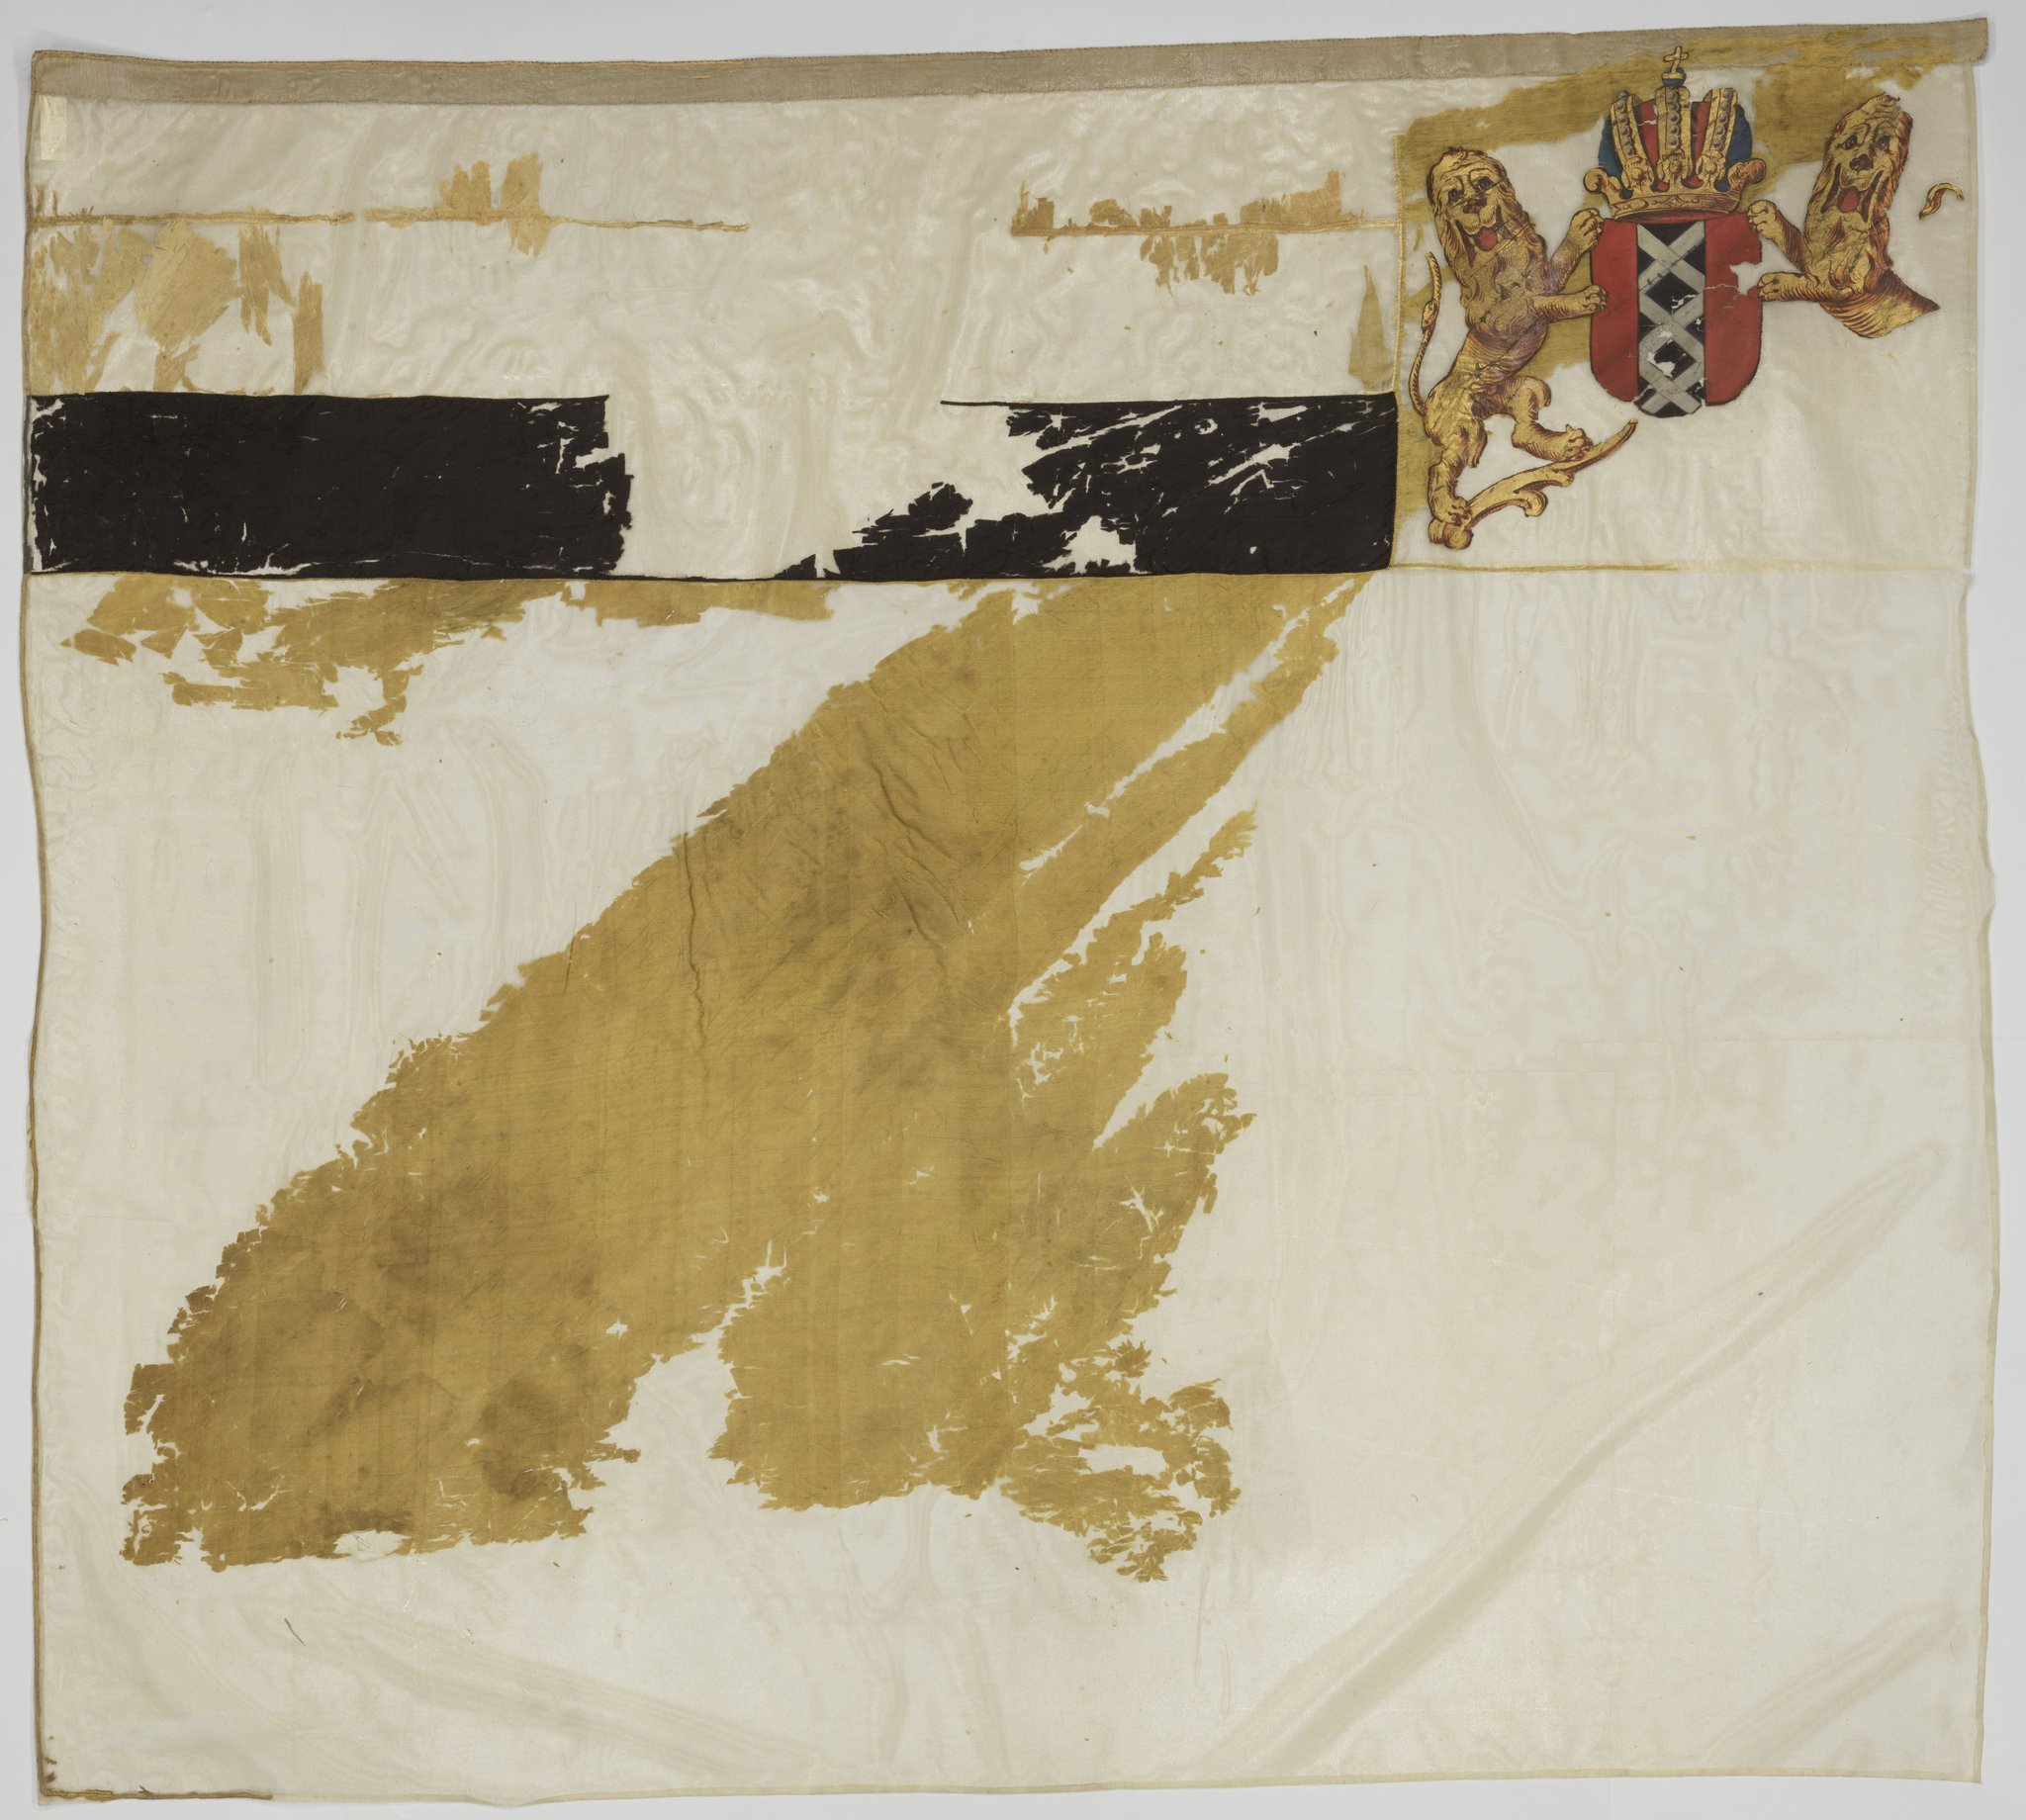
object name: banner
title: Vaandel van het gele regiment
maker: Anonymous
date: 1700-1800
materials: paint, silk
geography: amsterdam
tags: amsterdam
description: Geel vaandel. Voorkant en paradekant identiek. Langs de bovenzijde drie banen rood-wit-zwart. In de bovenhals een gele rechthoek met het wapen van Amsterdam, gehouden door twee klimmende aanziende leeuwen en gedekt door keizerskroon. Het lofwerk onder het wapen is slechts gedeeltelijk over.